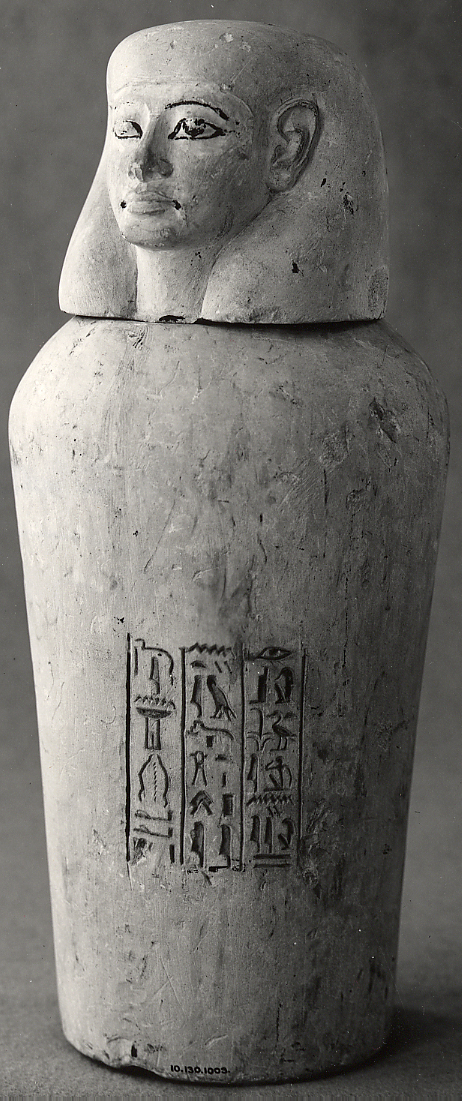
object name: canopic jar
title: Canopic jar of princess Any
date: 1550-1295 BCE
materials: limestone, linen, paste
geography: egypt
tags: princesses,hieroglyphs